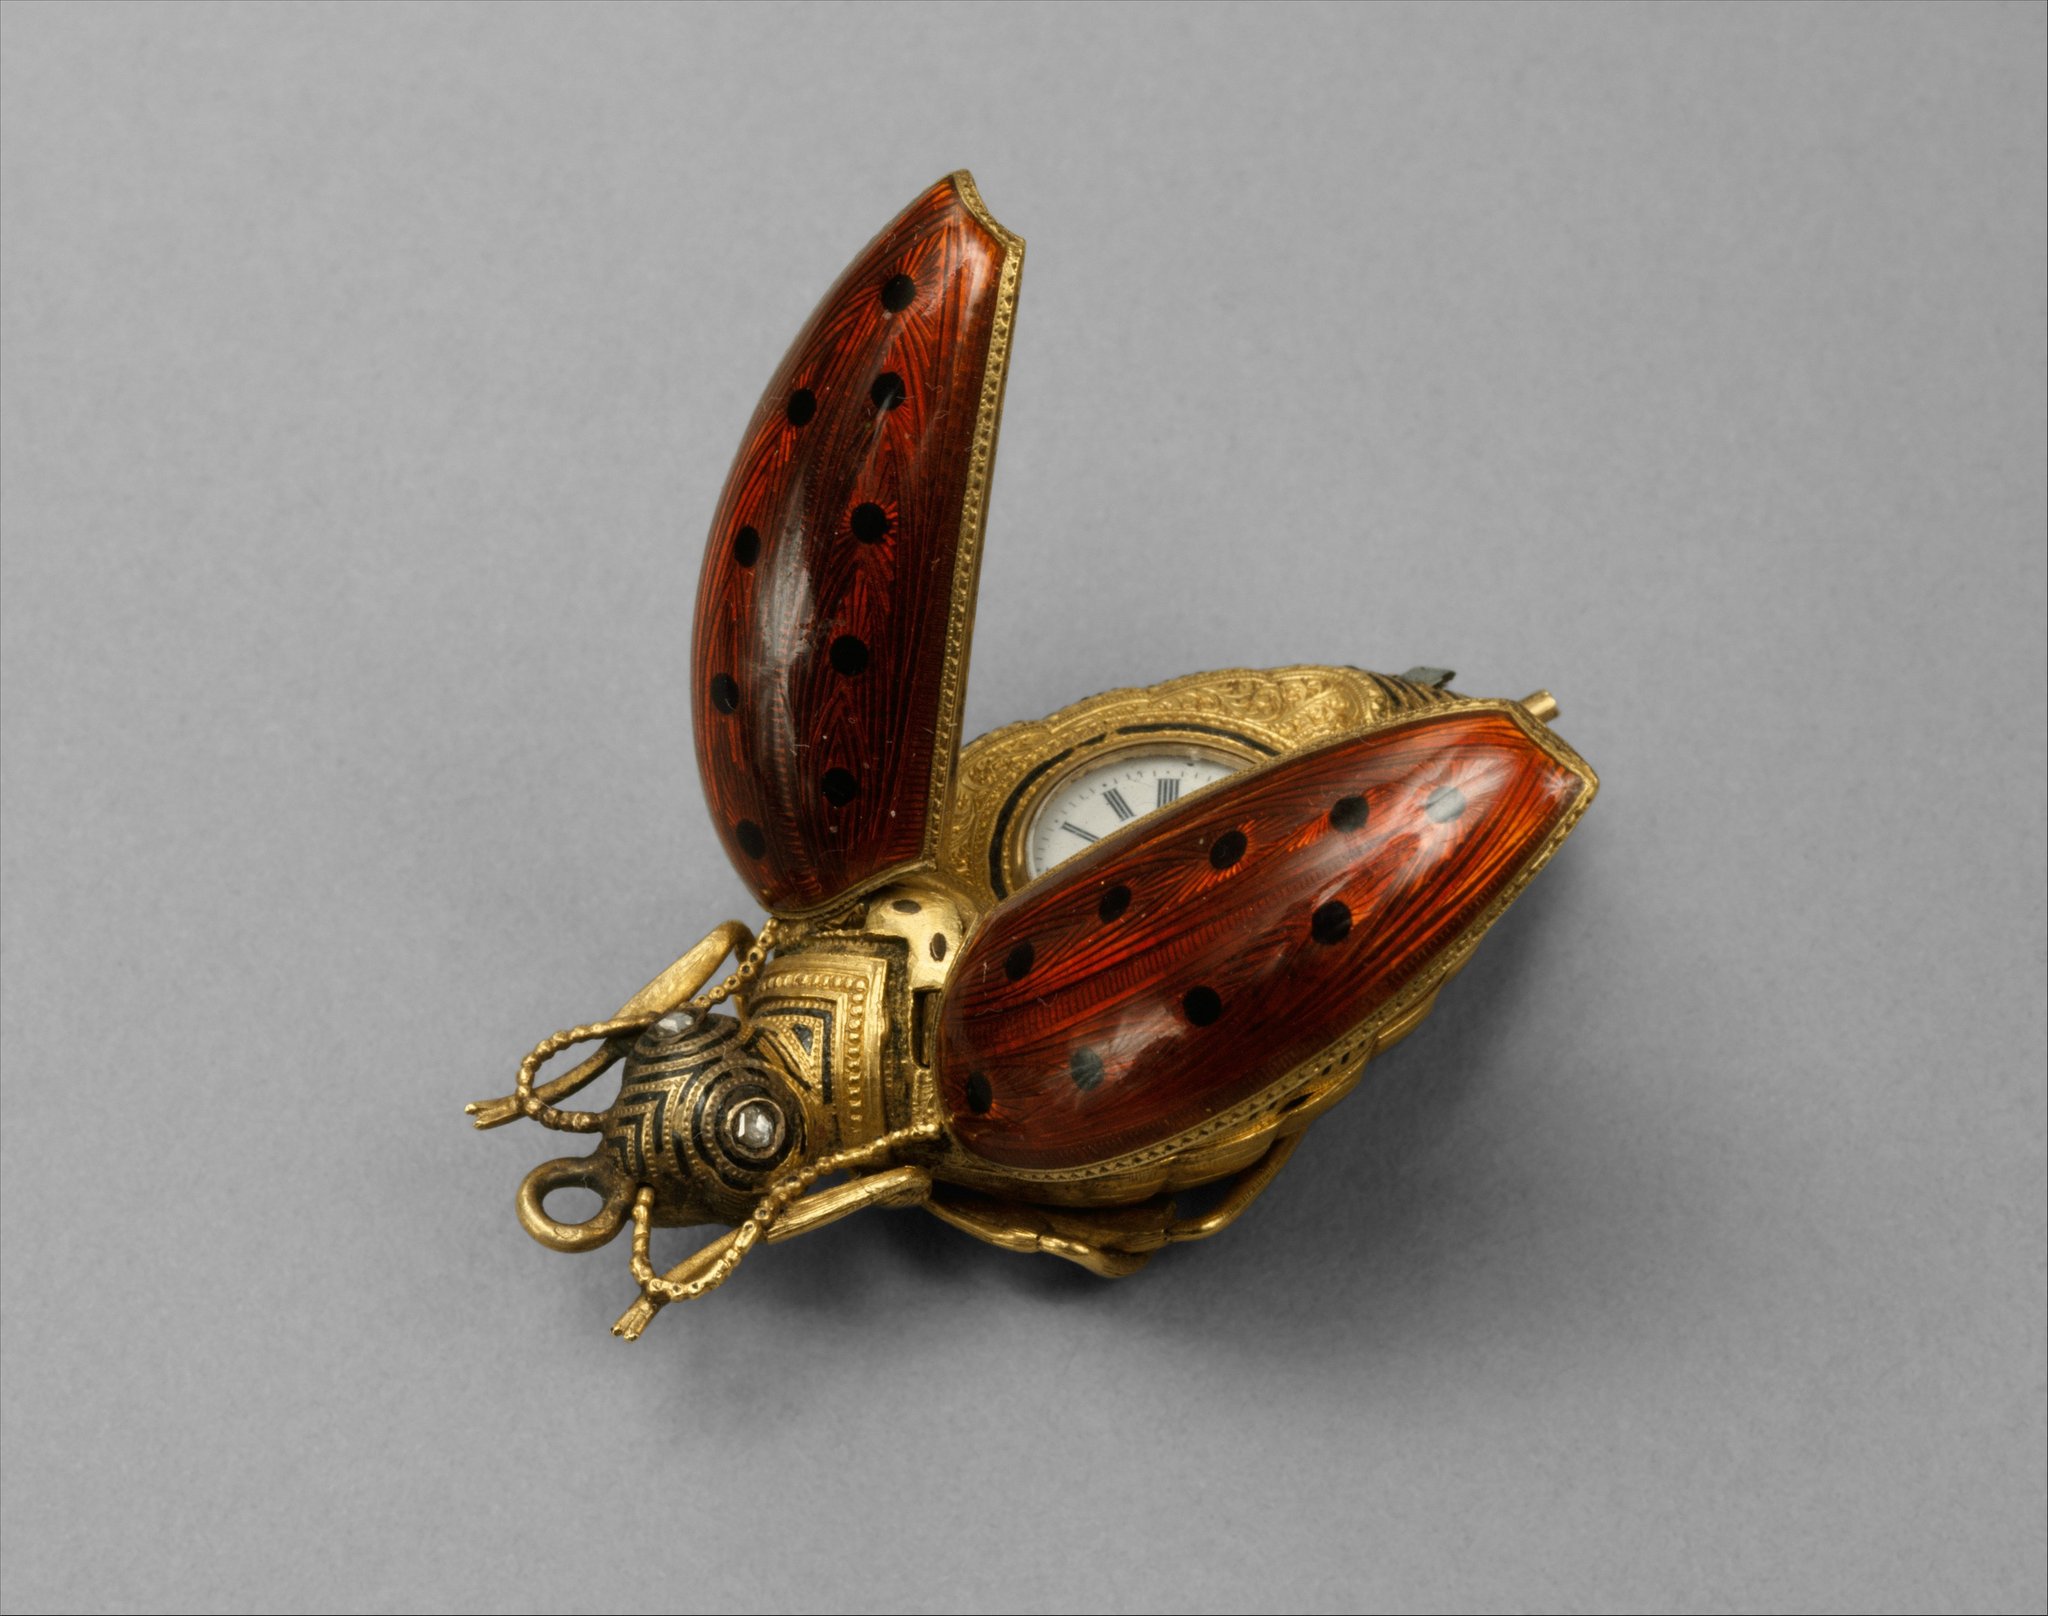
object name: watch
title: Watch in the form of a beetle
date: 1850-1860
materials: enamel, gold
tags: insects